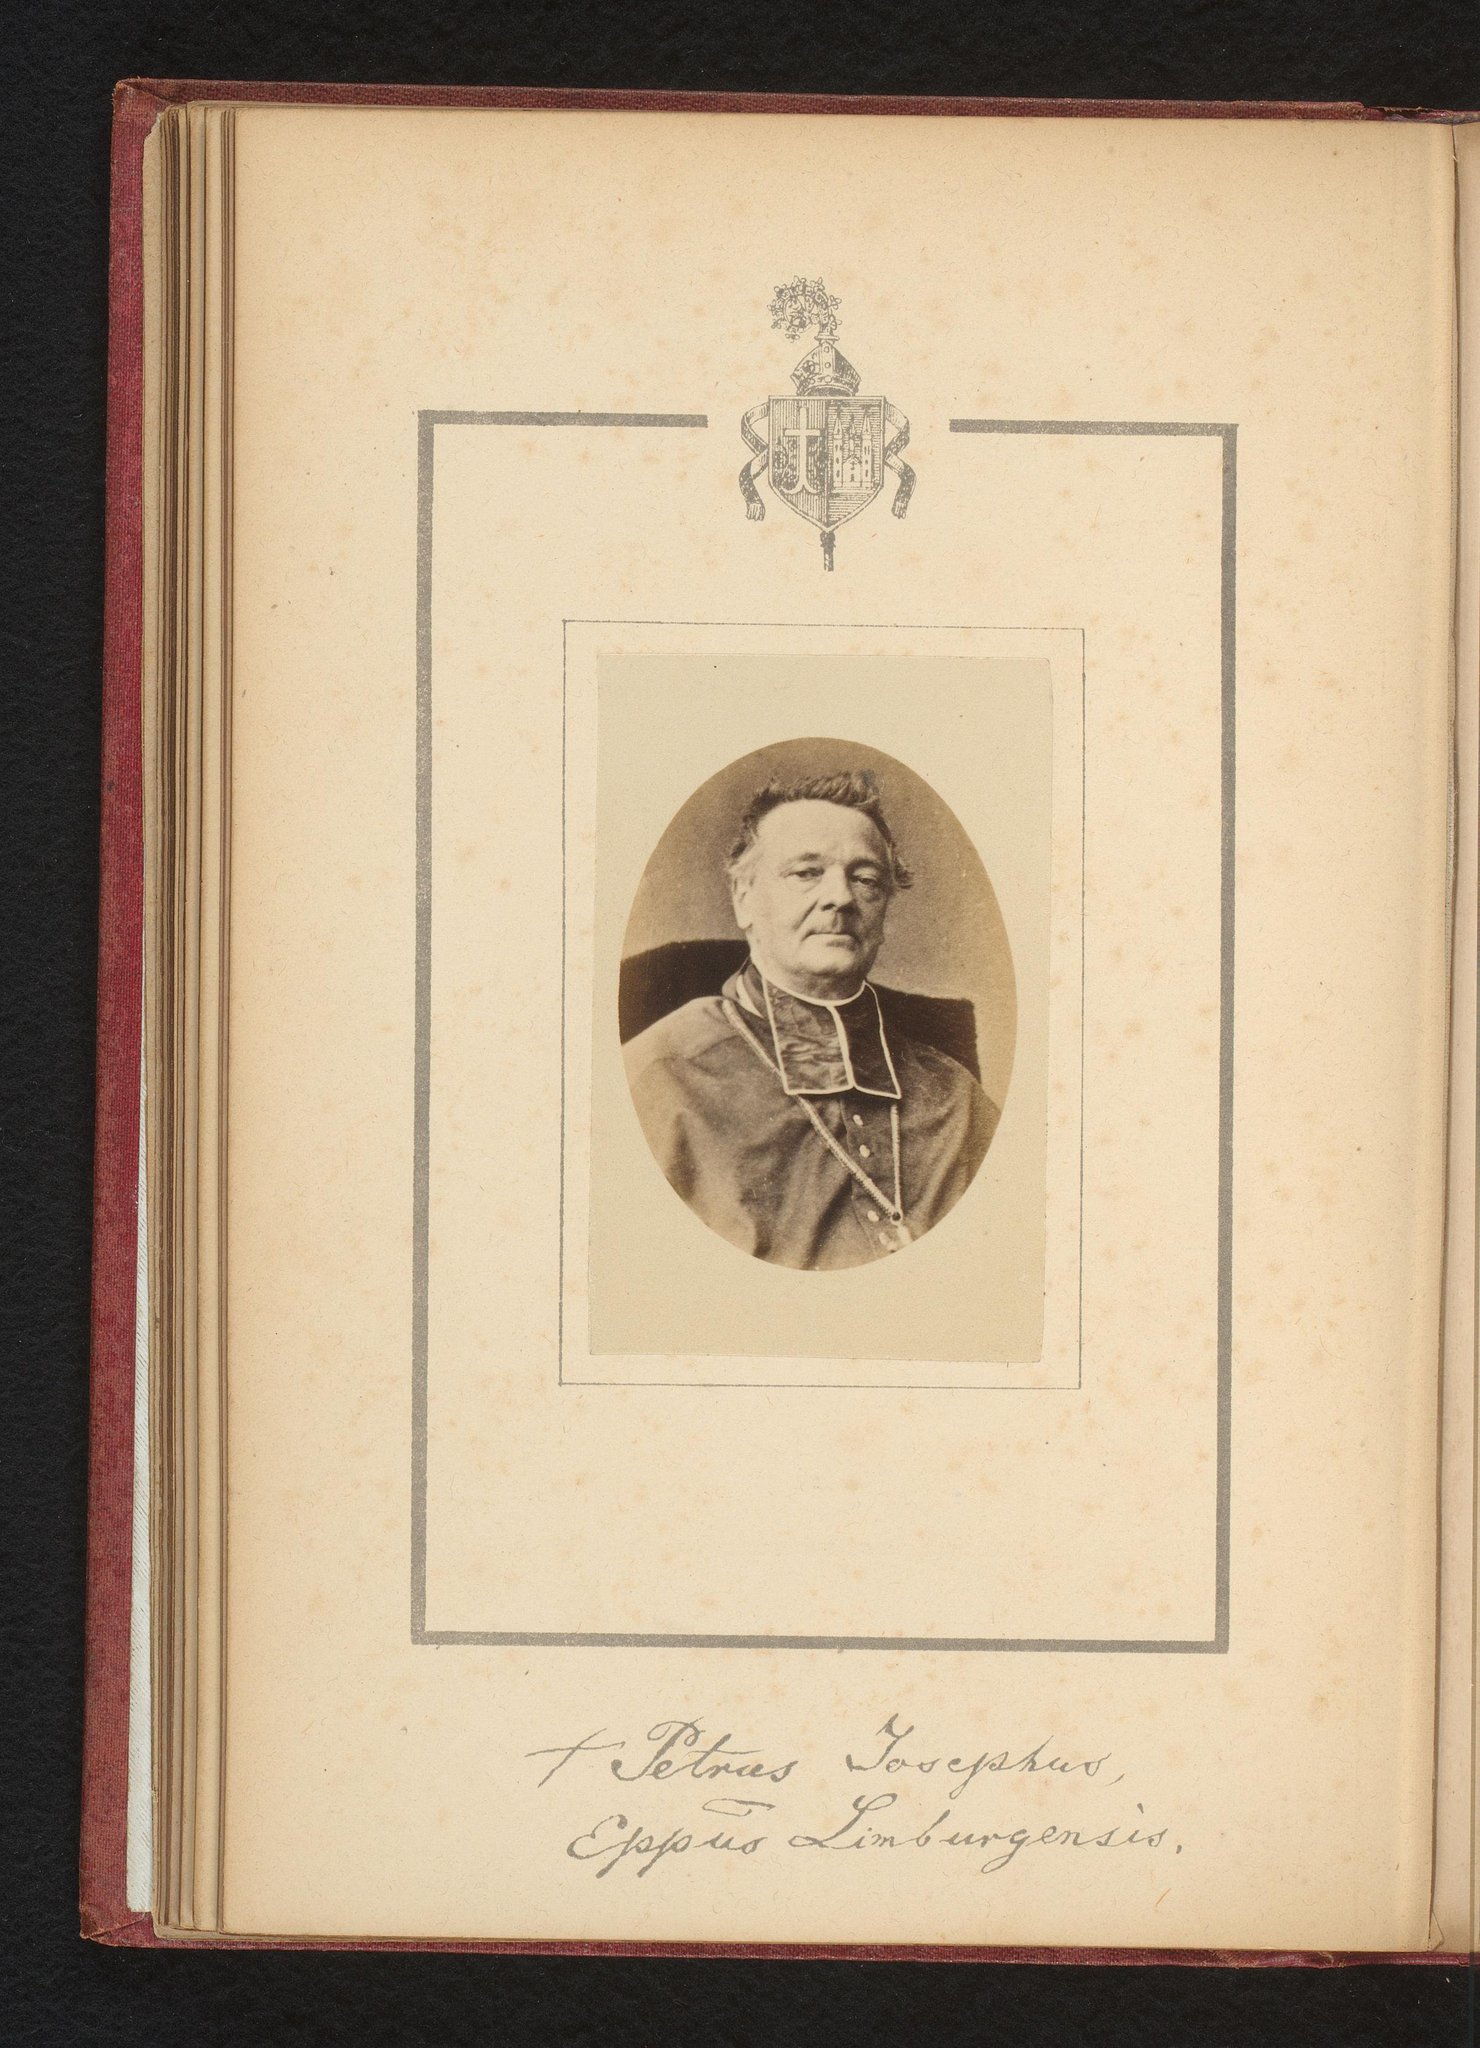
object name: page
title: Portret van bisschop Peter Joseph Blum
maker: Anonymous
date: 1863-1873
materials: photographic support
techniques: albumen print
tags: archbishop, bishop, etc. (roman catholic)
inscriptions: inscription: ‘Petrus Josephus, [...] Limburgensis.’